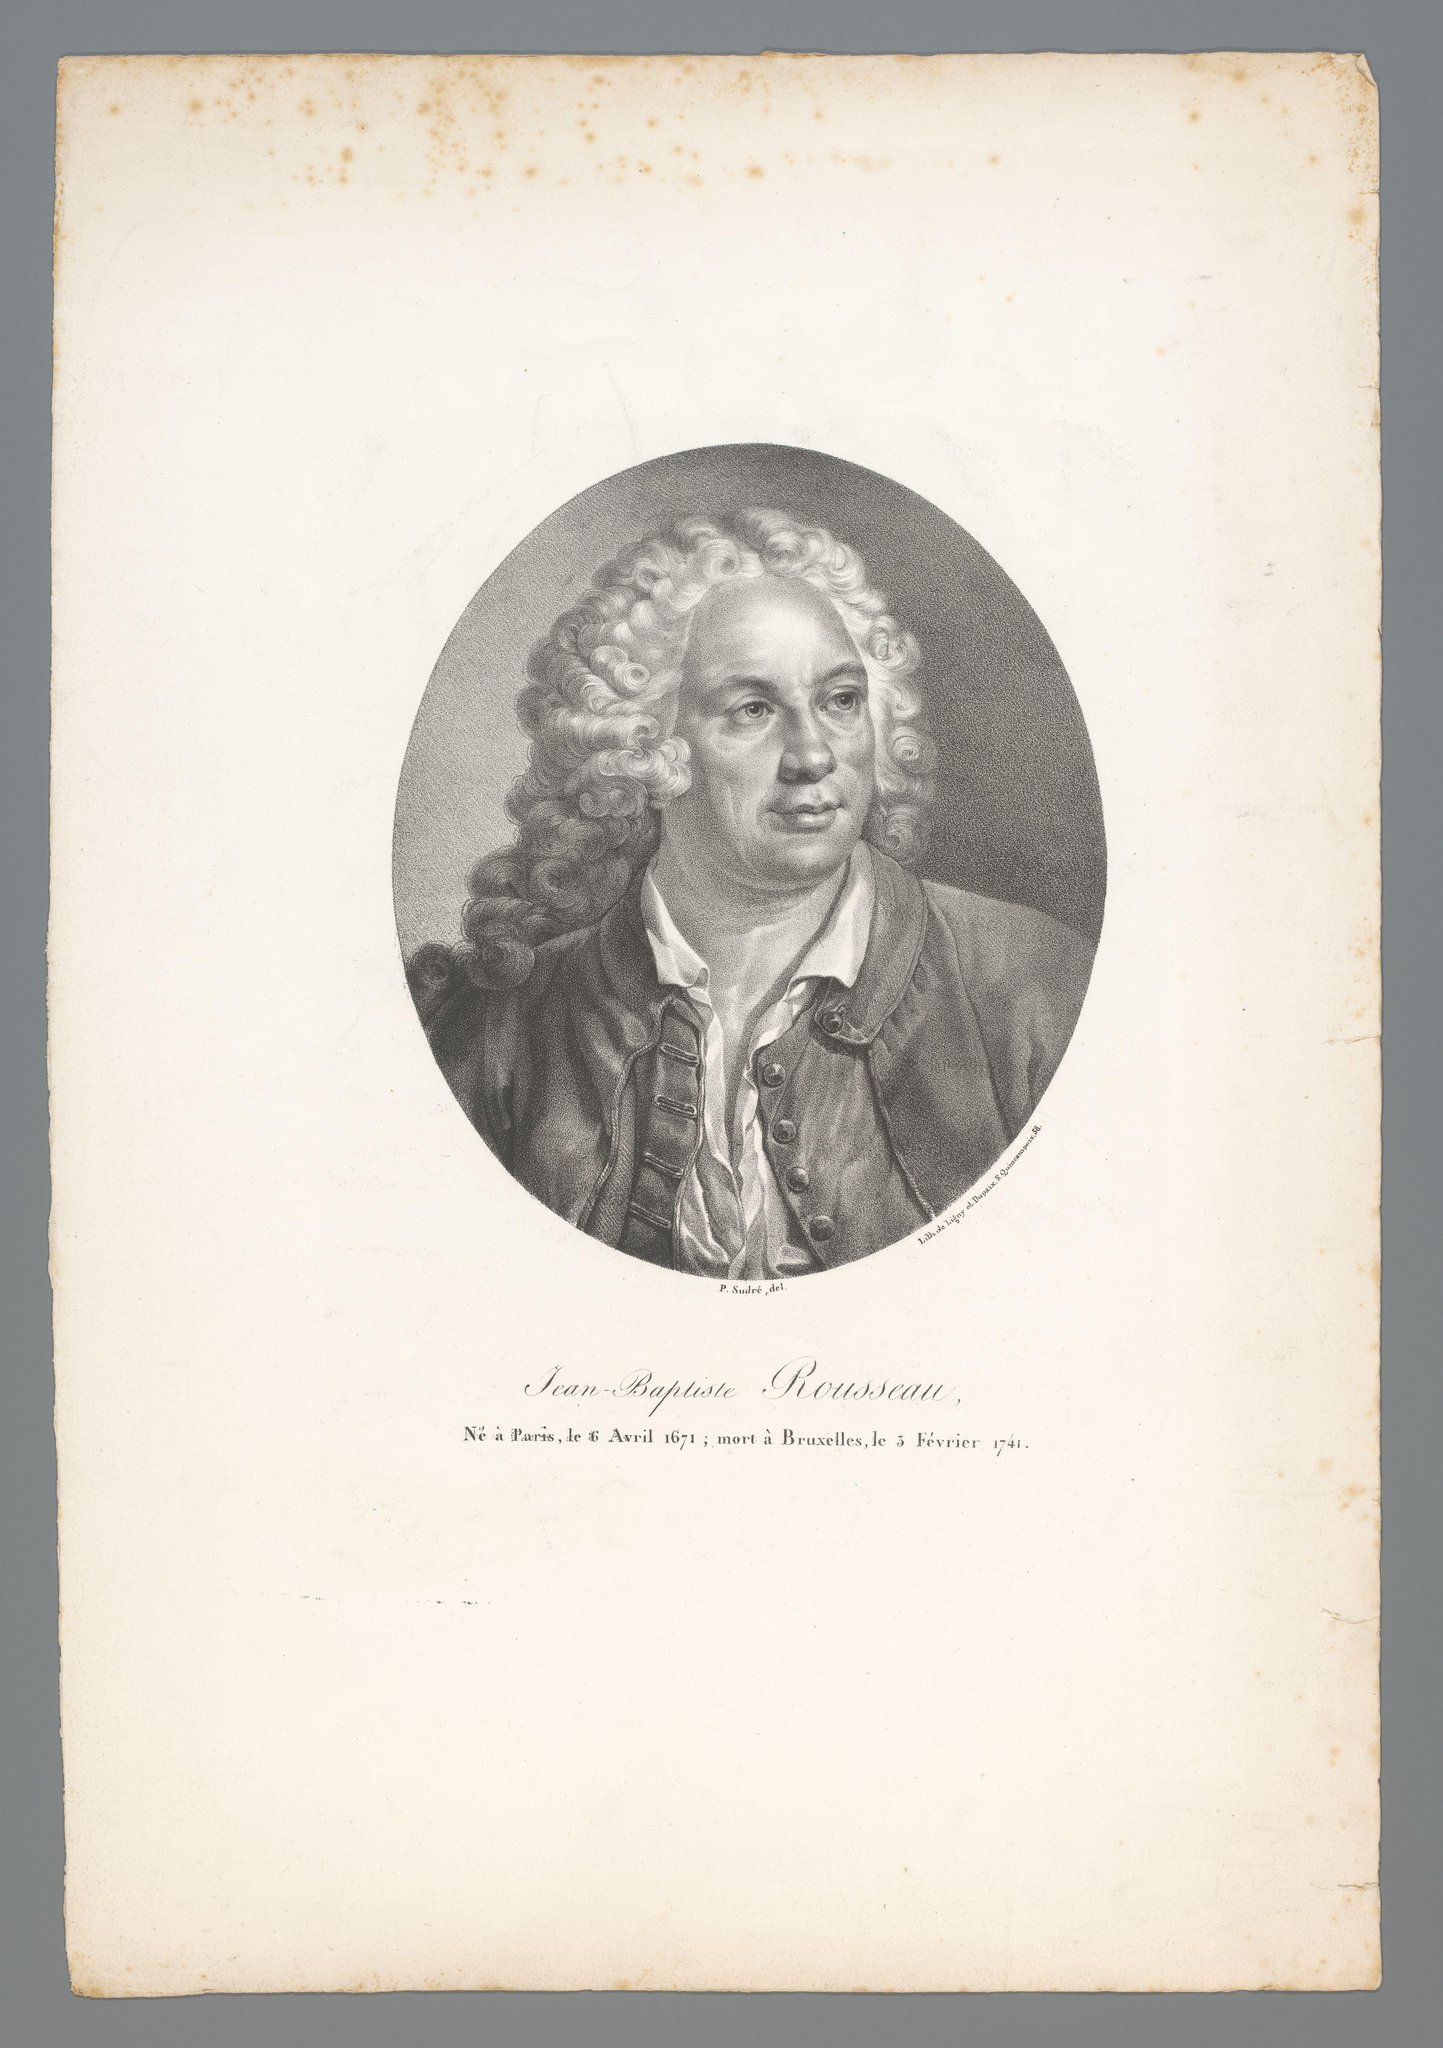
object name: print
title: Le panthéon français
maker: jean pierre sudre (1783-1866)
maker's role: painter, print maker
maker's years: 1783-1866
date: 1820-1827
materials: paper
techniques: lithograph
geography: paris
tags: paris, jean baptiste rousseau (1669-1741), historical persons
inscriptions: collector's mark: Lugt 2228